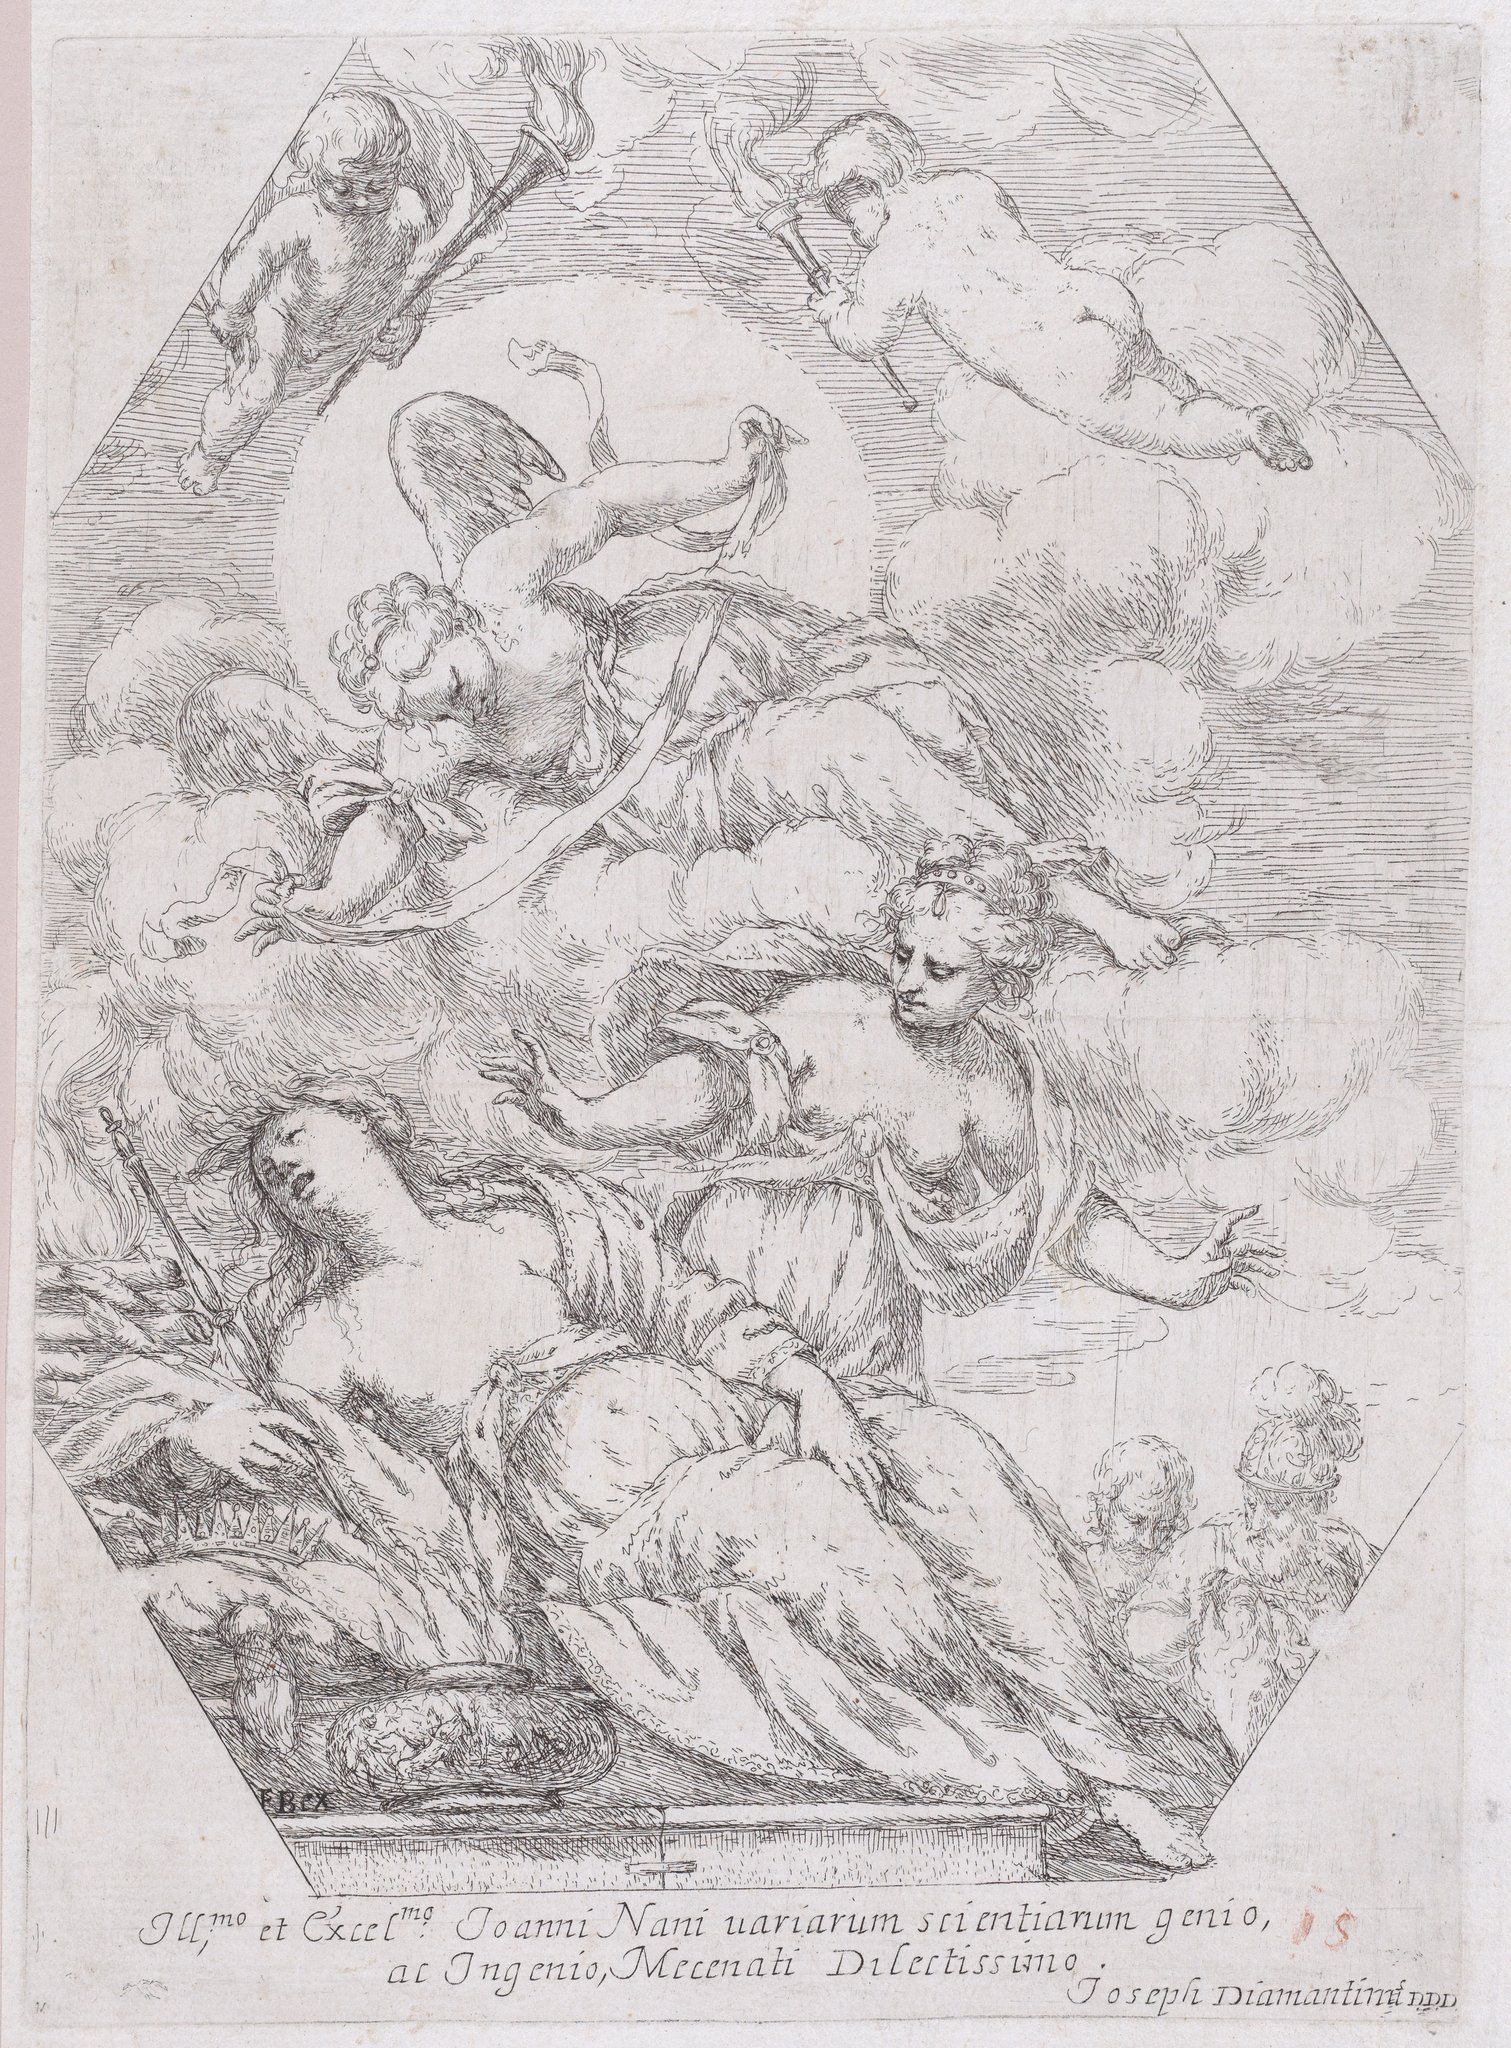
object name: print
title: Dido on the Funeral Pyre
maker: giuseppe diamantini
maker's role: artist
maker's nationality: italian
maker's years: 1621-1705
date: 1650-1700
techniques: etching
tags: women,dido